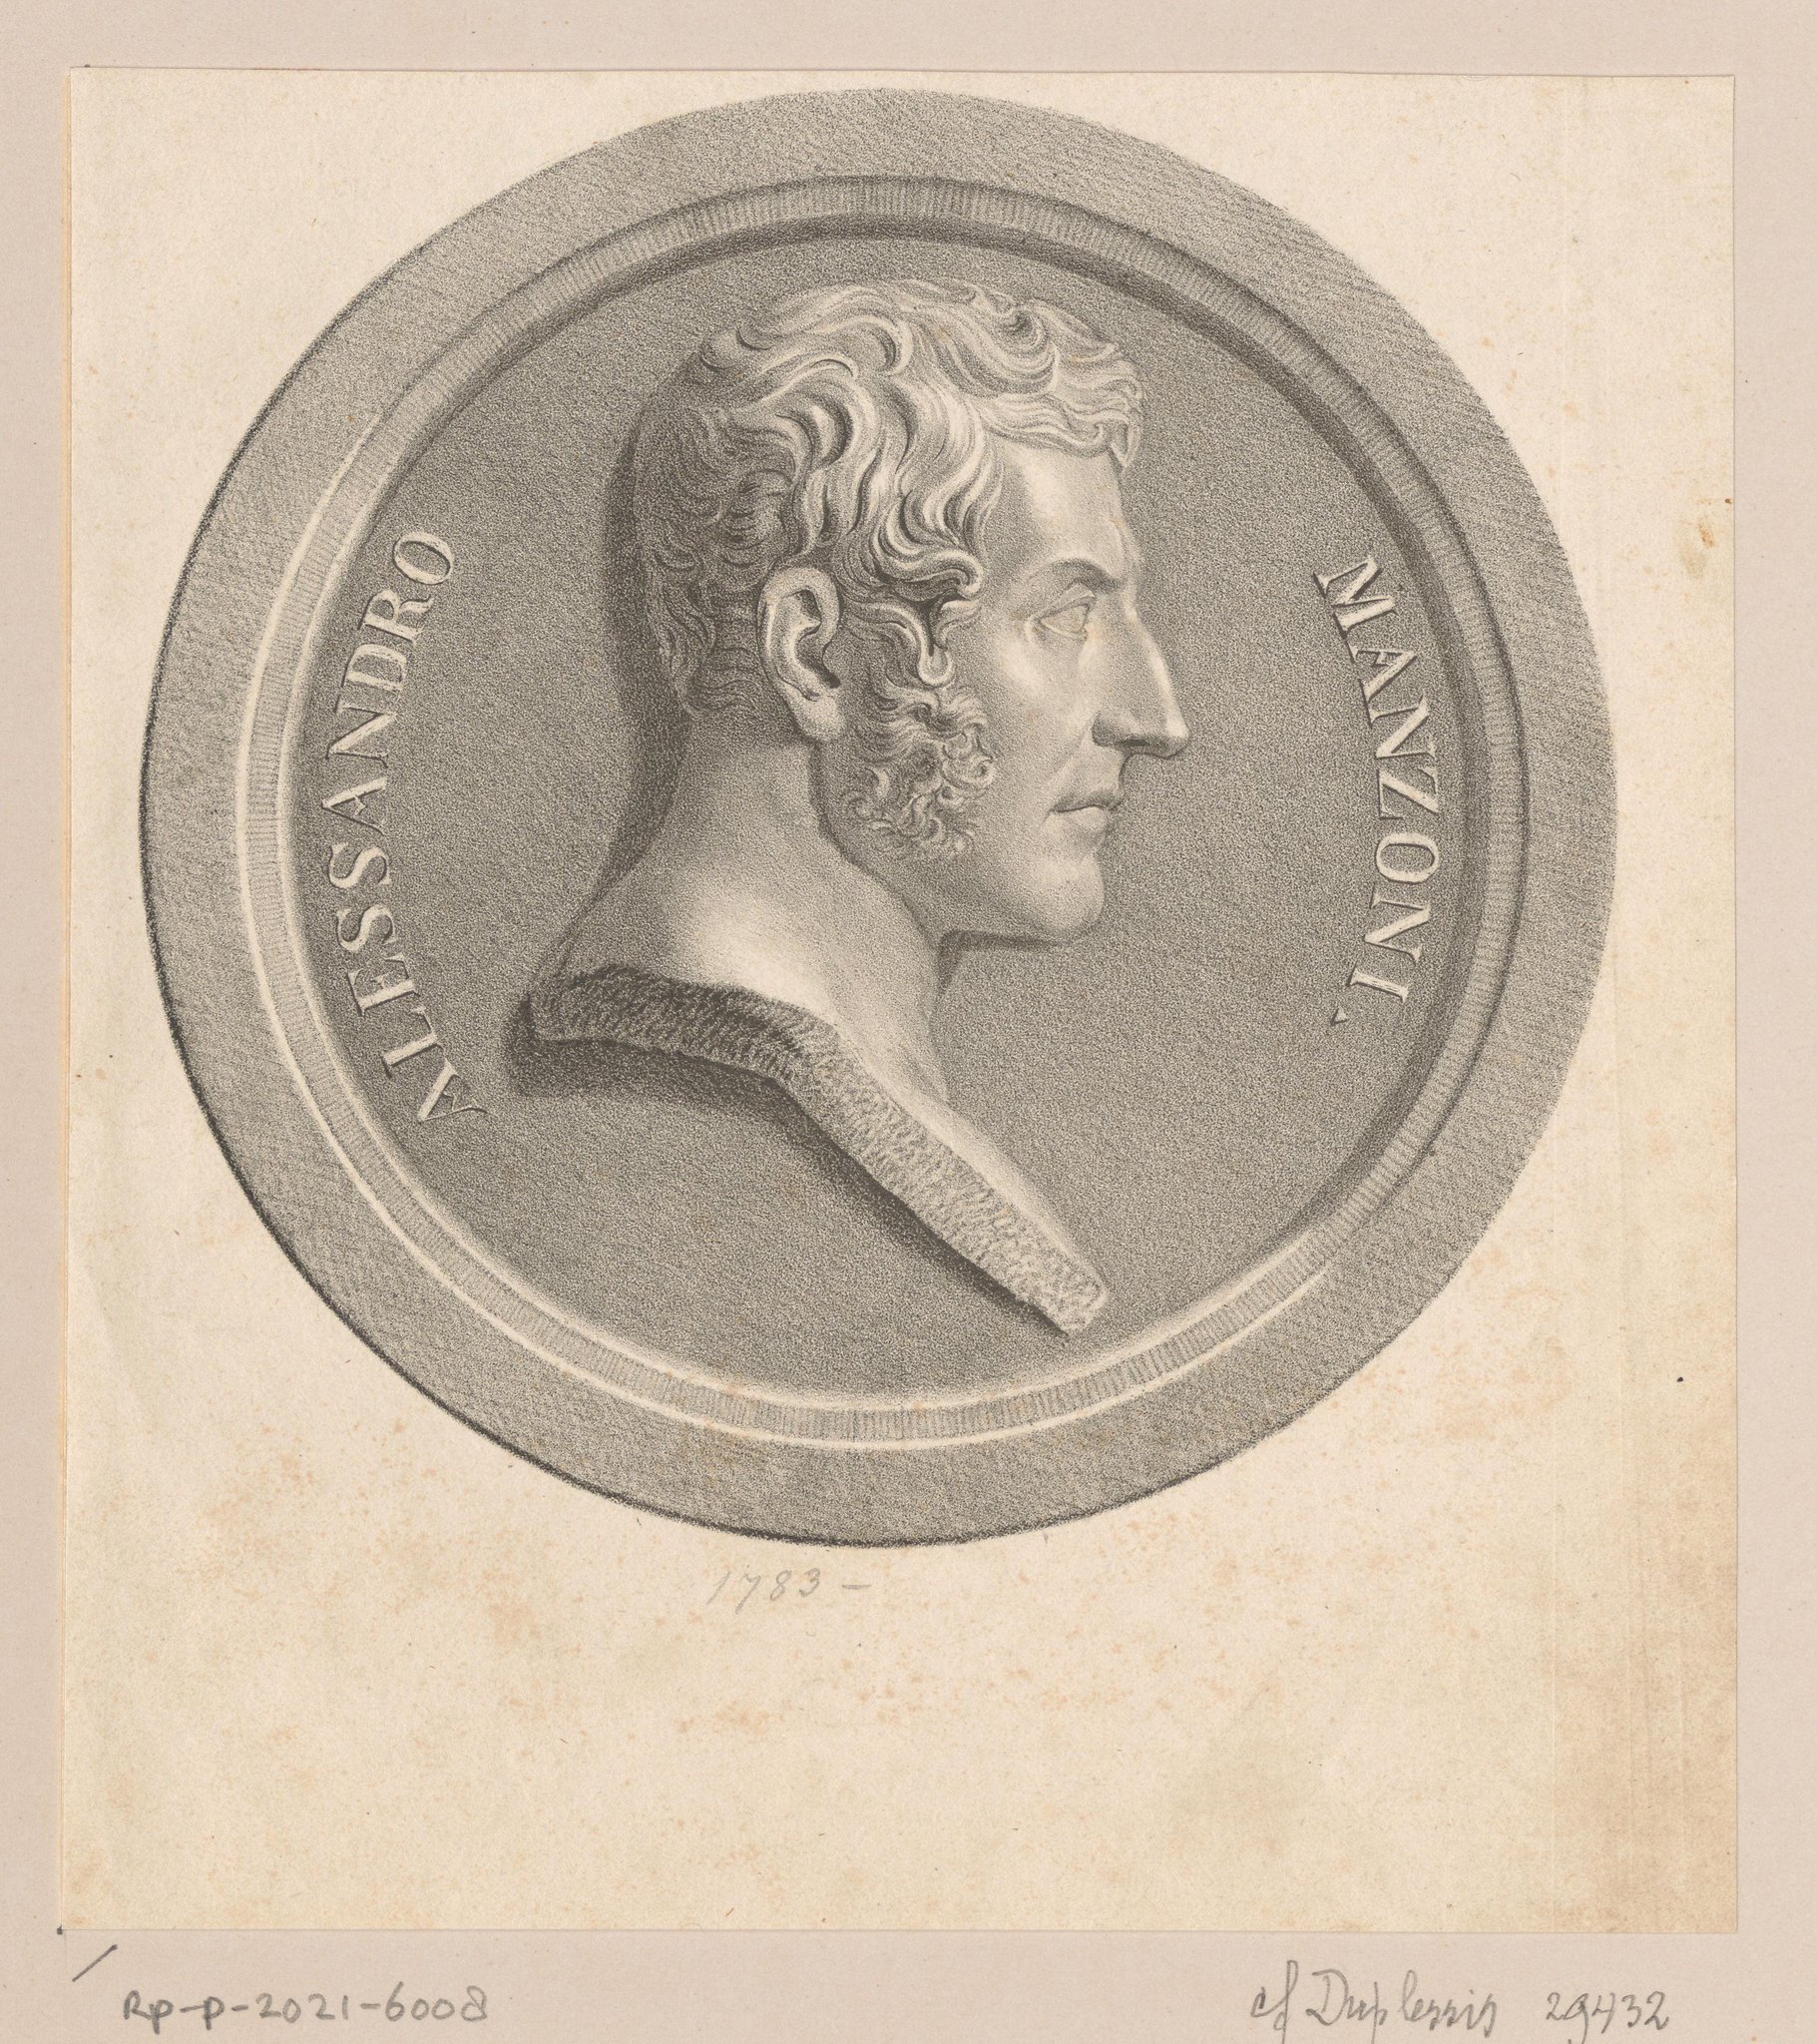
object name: print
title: Penning met het portret van Alessandro Manzoni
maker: Anonymous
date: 1810-1899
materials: paper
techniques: lithograph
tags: historical persons, portrait of a writer, medal (considered as a piece of sculpture, regardless of its specific function)